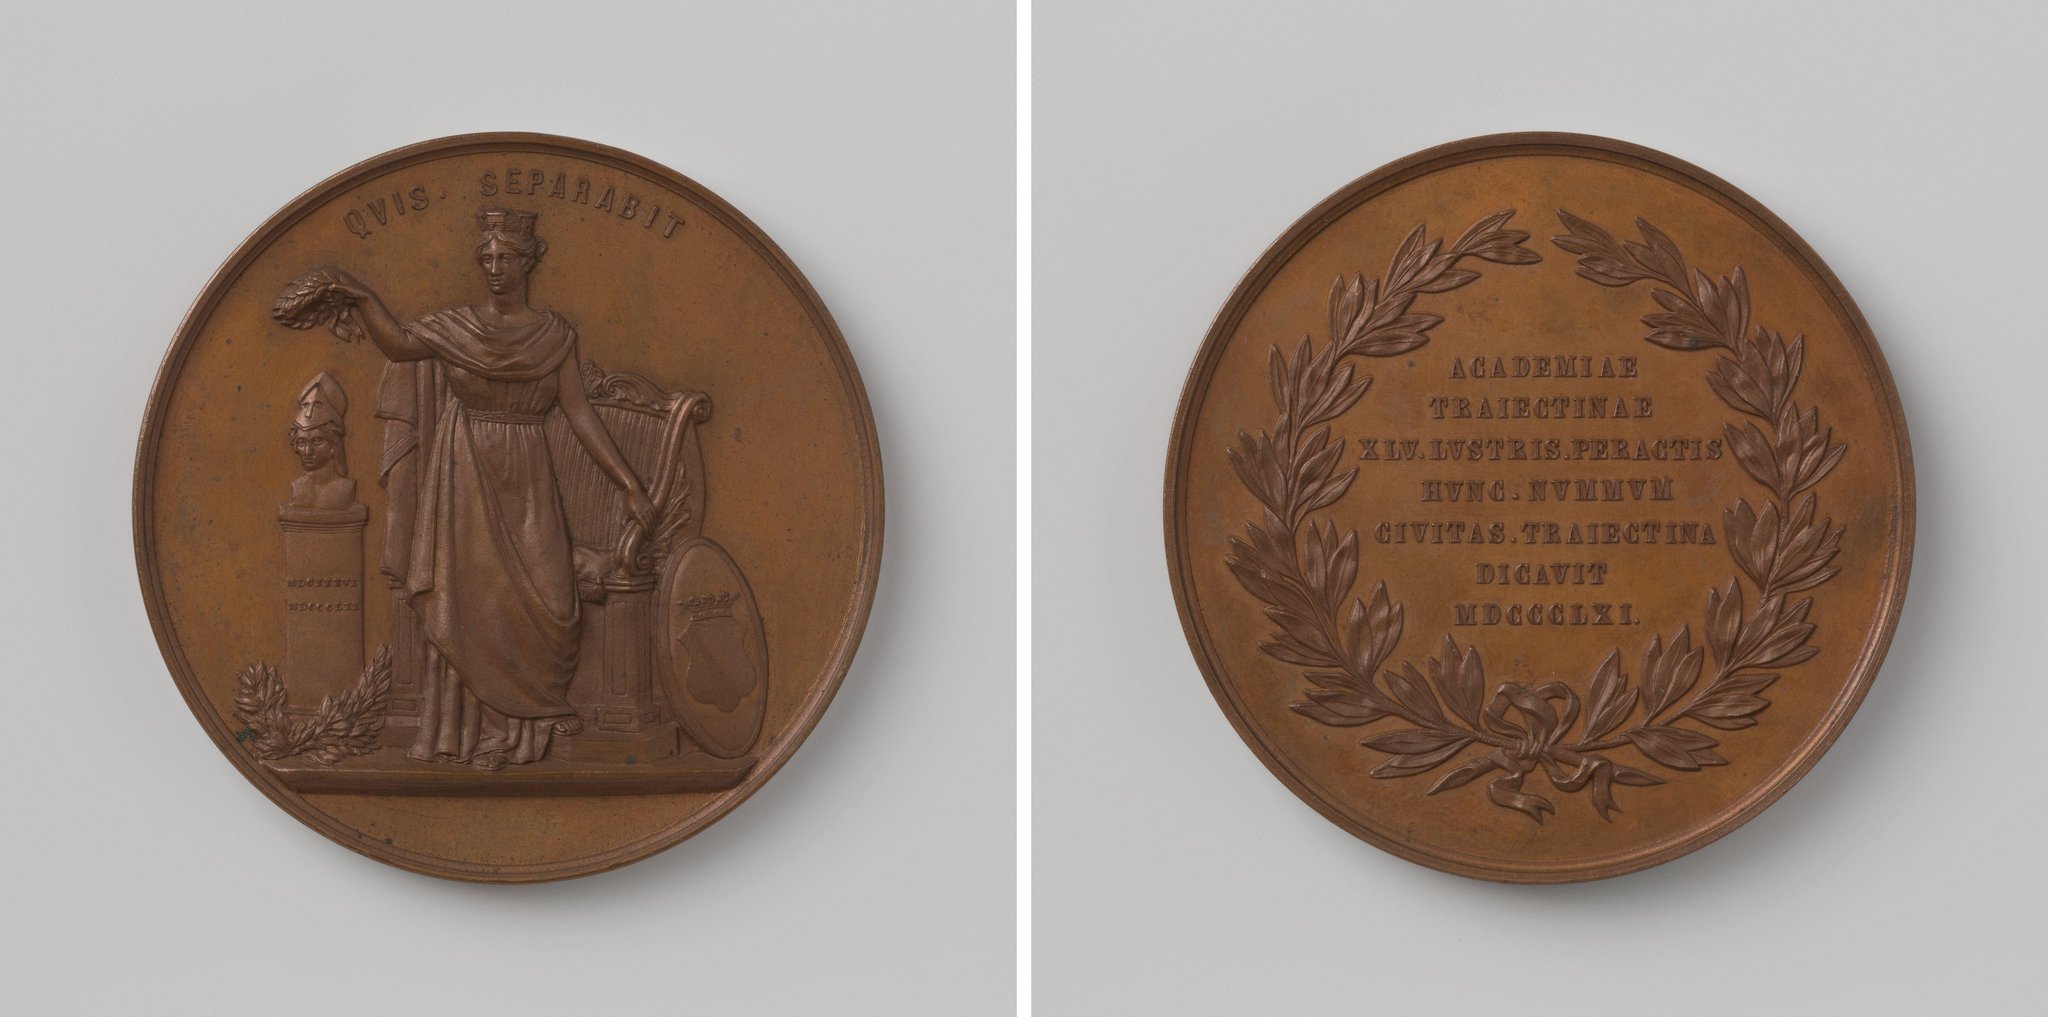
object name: history medal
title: Tweehondervijfentwintigjarig bestaan van de Universiteit van Utrecht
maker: johan philip menger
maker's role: medailleur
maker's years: 1818-1895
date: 1861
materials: bronze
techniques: striking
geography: utrecht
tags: utrecht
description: Bronzen penning. Voorzijde: gekroonde vrouw, voorstellende stad Utrecht, houdt zich met linkerhand vast aan zetel, waaruit zij net is opgestaan en waartegen wapenschild leunt, en houdt met rechterhand krans boven buste van Pallas op sokkel met opschrift binnen omschrift. Keerzijde: opschrift binnen lauwerkrans